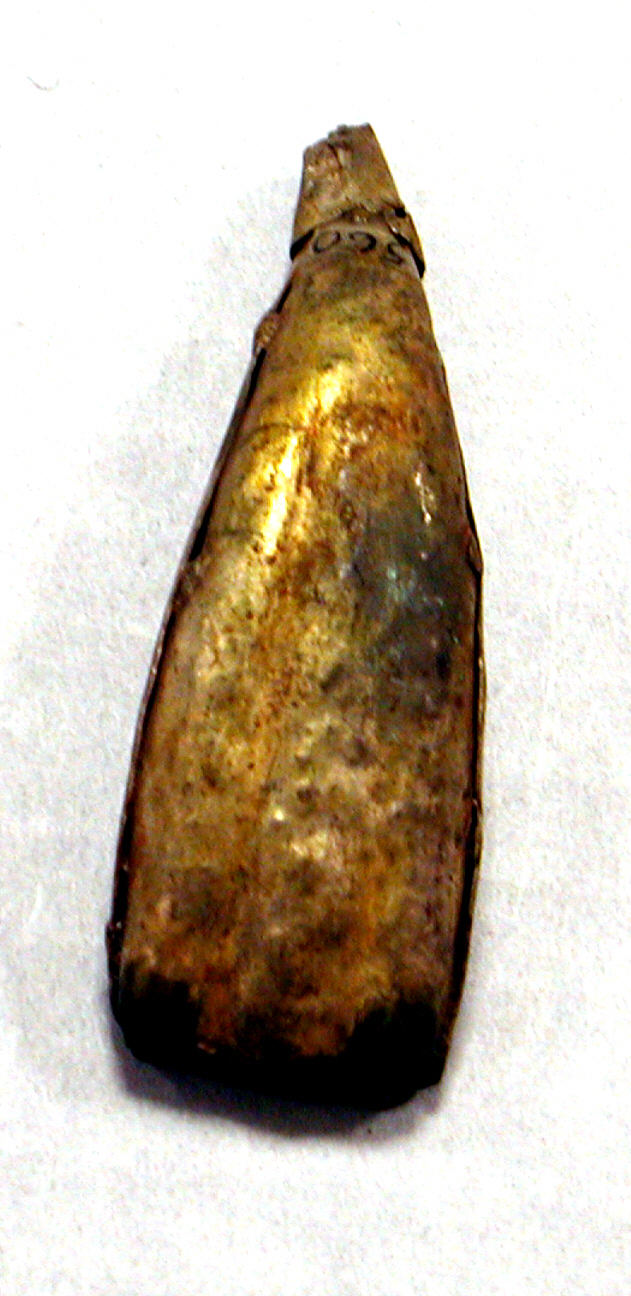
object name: ornament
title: Hammered Silver Petal Ornament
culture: peruvian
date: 701-1466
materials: gilt, silver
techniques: hammering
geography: peru